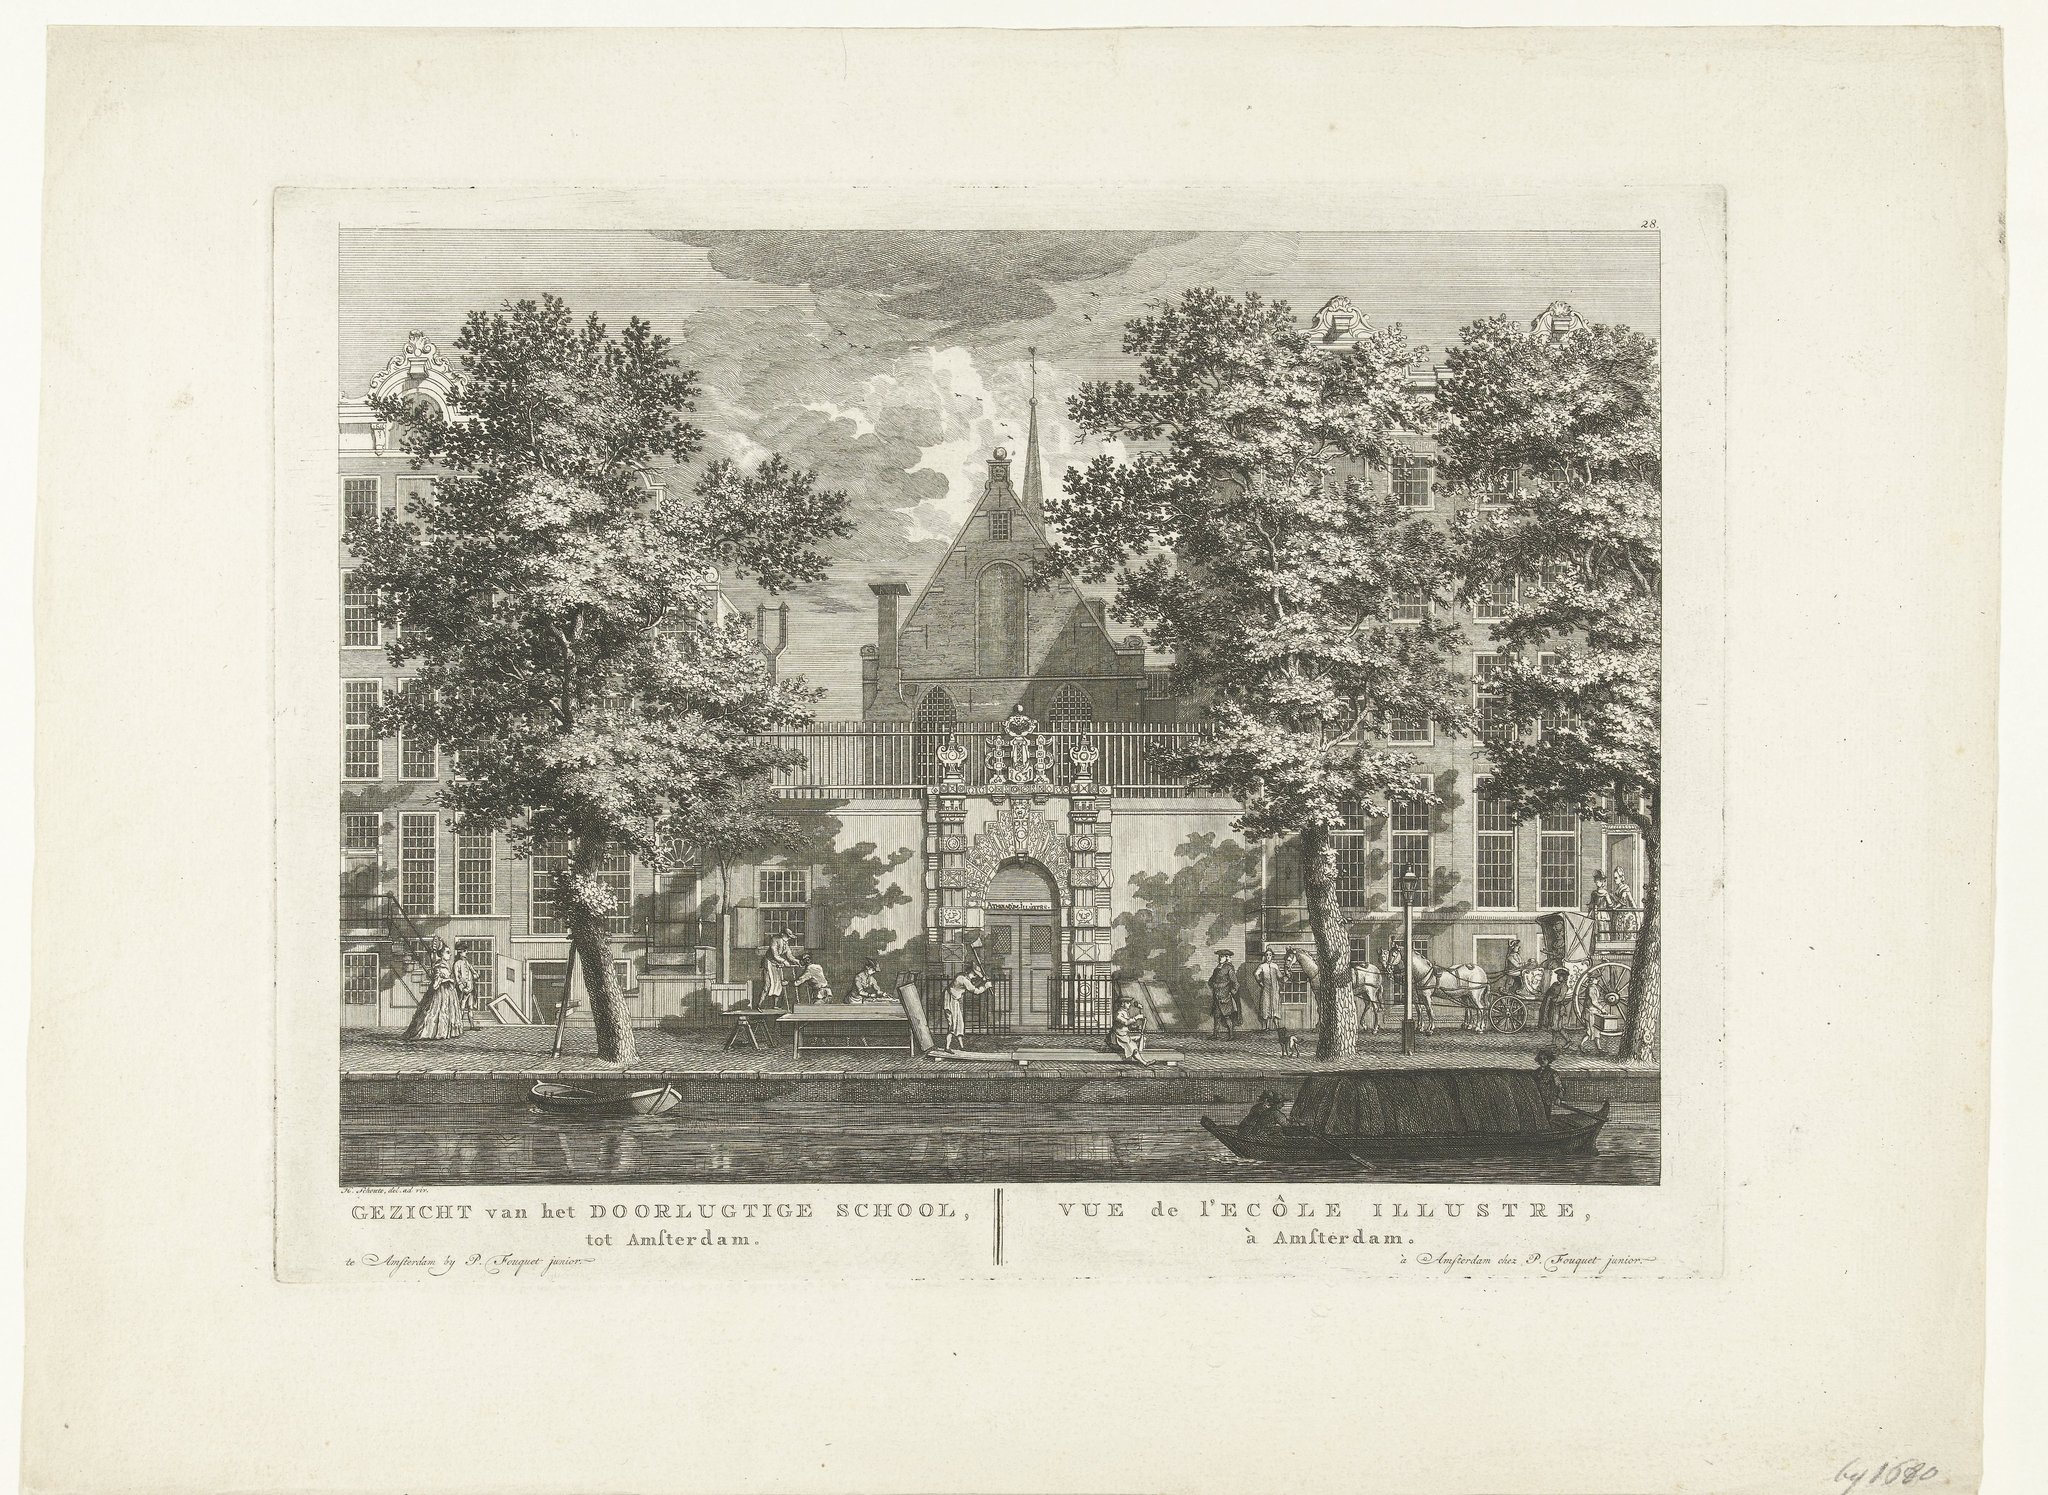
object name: print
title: Gezicht op het Athenaeum Illustre te Amsterdam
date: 1770-1783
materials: paper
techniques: engraving, etching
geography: amsterdam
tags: gate, entrance, university building, college, street (+ city(-scape) with figures, staffage)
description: Deze prent is ook gebruikt in de zogenaamde Atlas van Fouquet.* Pierre Fouquet gaf vanaf 1760 stadsgezichten van Amsterdam - naar tekeningen van verschillende kunstenaars, gemaakt door verschillende prentmakers - uit. Deze prenten werden aanvankelijk los of in series verkocht. Zoals toen gebruikelijk kon de koper de prenten zelf laten inbinden. Hiertoe gaf Fouquet tussen 1778 en 1783 een titelblad, plattegrond en inhoudsopgave van de tot dusver 100 uitgegeven prenten uit (1). Gezien de inhoud afhankelijk was van wat de koper had verzameld verschilt de inhoud van de verschillende bewaarde Fouquetatlassen onder deze titel sterk. Ook zijn er exemplaren bekend waar tevens andere prenten aan zijn toegevoegd. Omdat er behoefte bleek aan uitleg bij de platen werd in 1783 een nieuwe versie van de atlas uitgegeven, aangevuld met tekst en twee prenten. De aangegeven volgorde veranderde maar de platen van de al eerder uitgegeven prenten bleven ongewijzigd. Deze uitgave werd in opdracht van Fouquet gedrukt bij Daniël Jean Changuion en Petrus den Hengst (2). Een tiental platen werd bijgewerkt en verscheen, met nieuw impressum, in het vervolg van Wagenaars geschiedenis van Amsterdam, uitgeven door Petrus Conradi en Folkert van der Plaats (3). Een aantal jaar na het overlijden van Fouquet kwam Evert Maaskamp met een nieuwe uitgave van de atlas, met verbeterde tekst en toevoeging van twee prenten. Op alle platen verwijderde hij het oude en liet hij zijn eigen impressum zetten (4). De huidige staat van de prent komt voor in exemplaren van de onder (1) en (2) genoemde werken. * Onder de Atlas van Fouquet of Fouquetatlas verstaan we de hieronder vermelde publicaties (1), (2) en (4). (1). Afbeeldingen van de wyd-vermaarde koopstad Amsterdam benevens des zelvs voornaamste gebouwen en gezigten alle naar het leeven getekend / Receuil des edifices les plus considerables et des plus belles vues, de la fameuse ville d'Amsterdam, dessinées d'après nature. Amsterdam: Pierre Fouquet, 1778-1783. (2). Nieuwe atlas, van de voornaamste gebouwen en gezigten der stad Amsterdam, met derzelver beknopte beschryvingen. 2 delen. Amsterdam: Daniël Jean Changuion en Petrus den Hengst [in opdracht van Pierre Fouquet], 1783. (3). Stijl, Simon. Amsterdam, in zyne geschiedenissen, voorregten, koophandel, gebouwen, kerkenstaat, schoolen, schutterye, gilden en regeeringe, beschreeven. Om te dienen ten vervolge op het werk van Jan Wagenaar (…). 10 delen. Amsterdam en Harlingen: Petrus Conradi en Folkert van der Plaats, 1788-1801. (4). Nieuwe atlas, van de voornaamste gebouwen en gezigten der stad Amsterdam. Met derzelver beknopte beschryvingen. Amsterdam: Evert Maaskamp, 1805. * Het aantal vermelde staten is gebaseerd op het aantal gevonden staten. Mogelijk zijn er meer staten van deze prent.